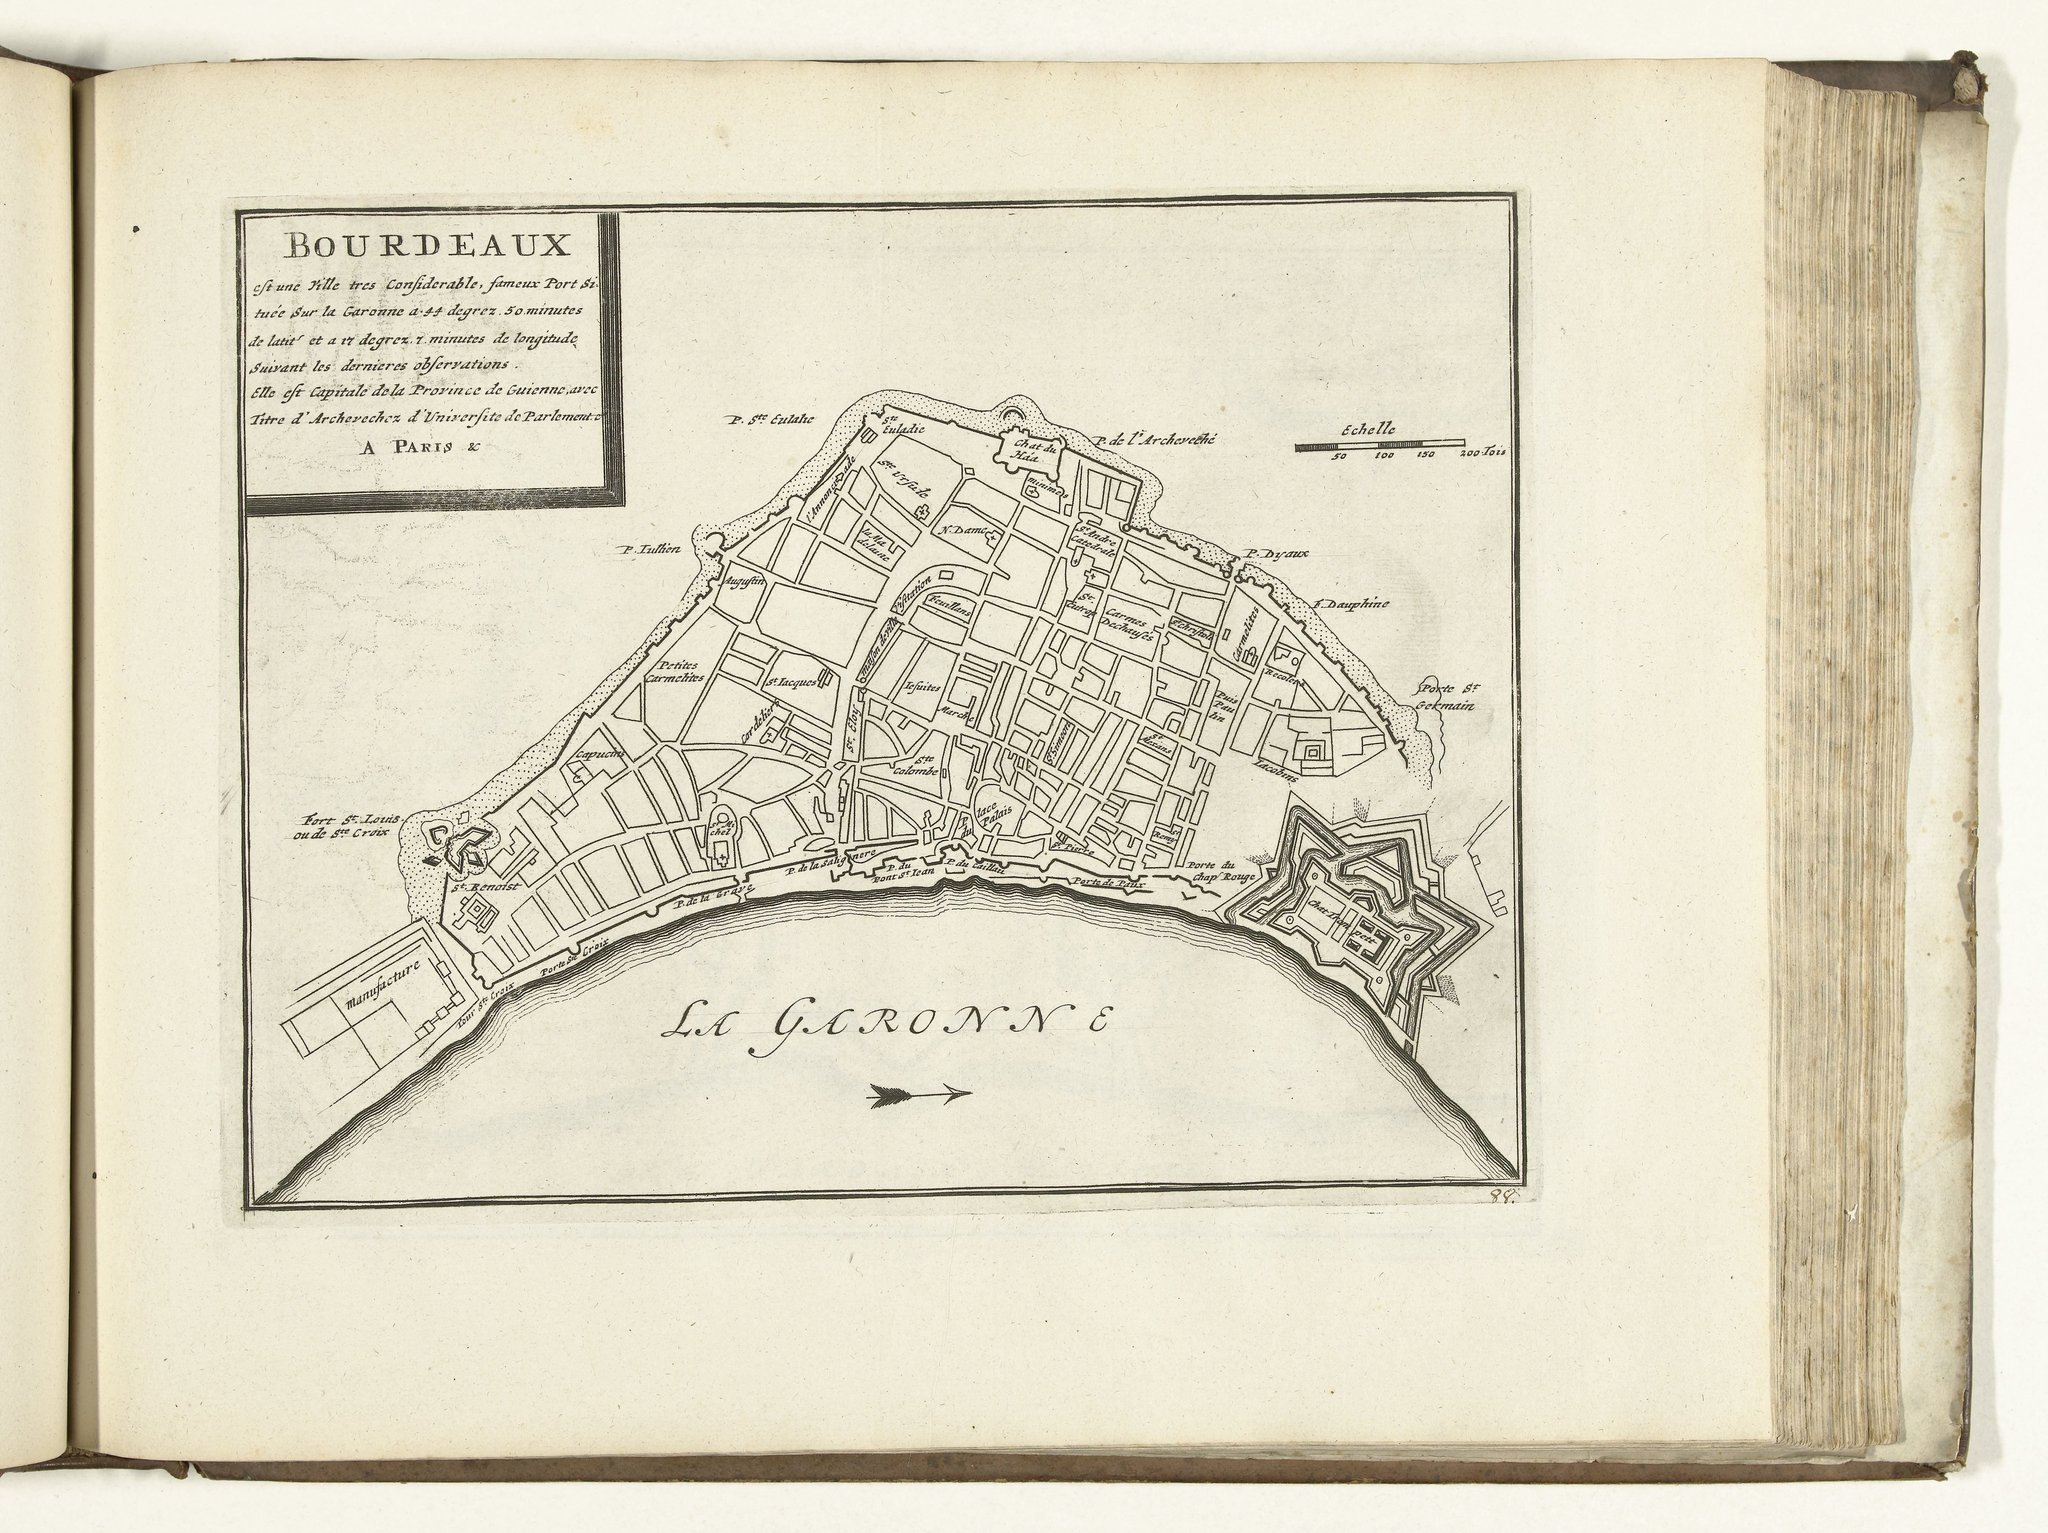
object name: map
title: Les Forces de l'Europe, Asie, Afrique et Amerique (...) Comme aussi les Cartes des Côtes de France et d'Espagne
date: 1726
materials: paper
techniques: etching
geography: northern netherlands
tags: fortress, maps of cities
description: Plattegrond van de versterkingen om de Franse stad Bordeaux. Plaat nr. 88 in deel IV van het prentwerk: Les Forces de l'Europe, Asie, Afrique et Amerique ... Comme aussi les Cartes des Côtes de France et d'Espagne uit 1726, dit eerste deel met 238 met de hand genummerde platen van vermaarde sterke steden en vestingen in het kader van de Spaanse Successieoorlog 1701-1713. Voor het merendeel zijn deze platen gekopieerd naar de anonieme Franse platen van vermaarde sterke steden en vestingen: in Les forces de l'Europe en in: Le theatre de la guerre, dans les Pays-Bas, beide oorspronkelijk uitgegeven door Nicolas de Fer te Parijs (1693-1697) in het kader van de Negenjarige Oorlog. Titel en opschriften in het Frans.